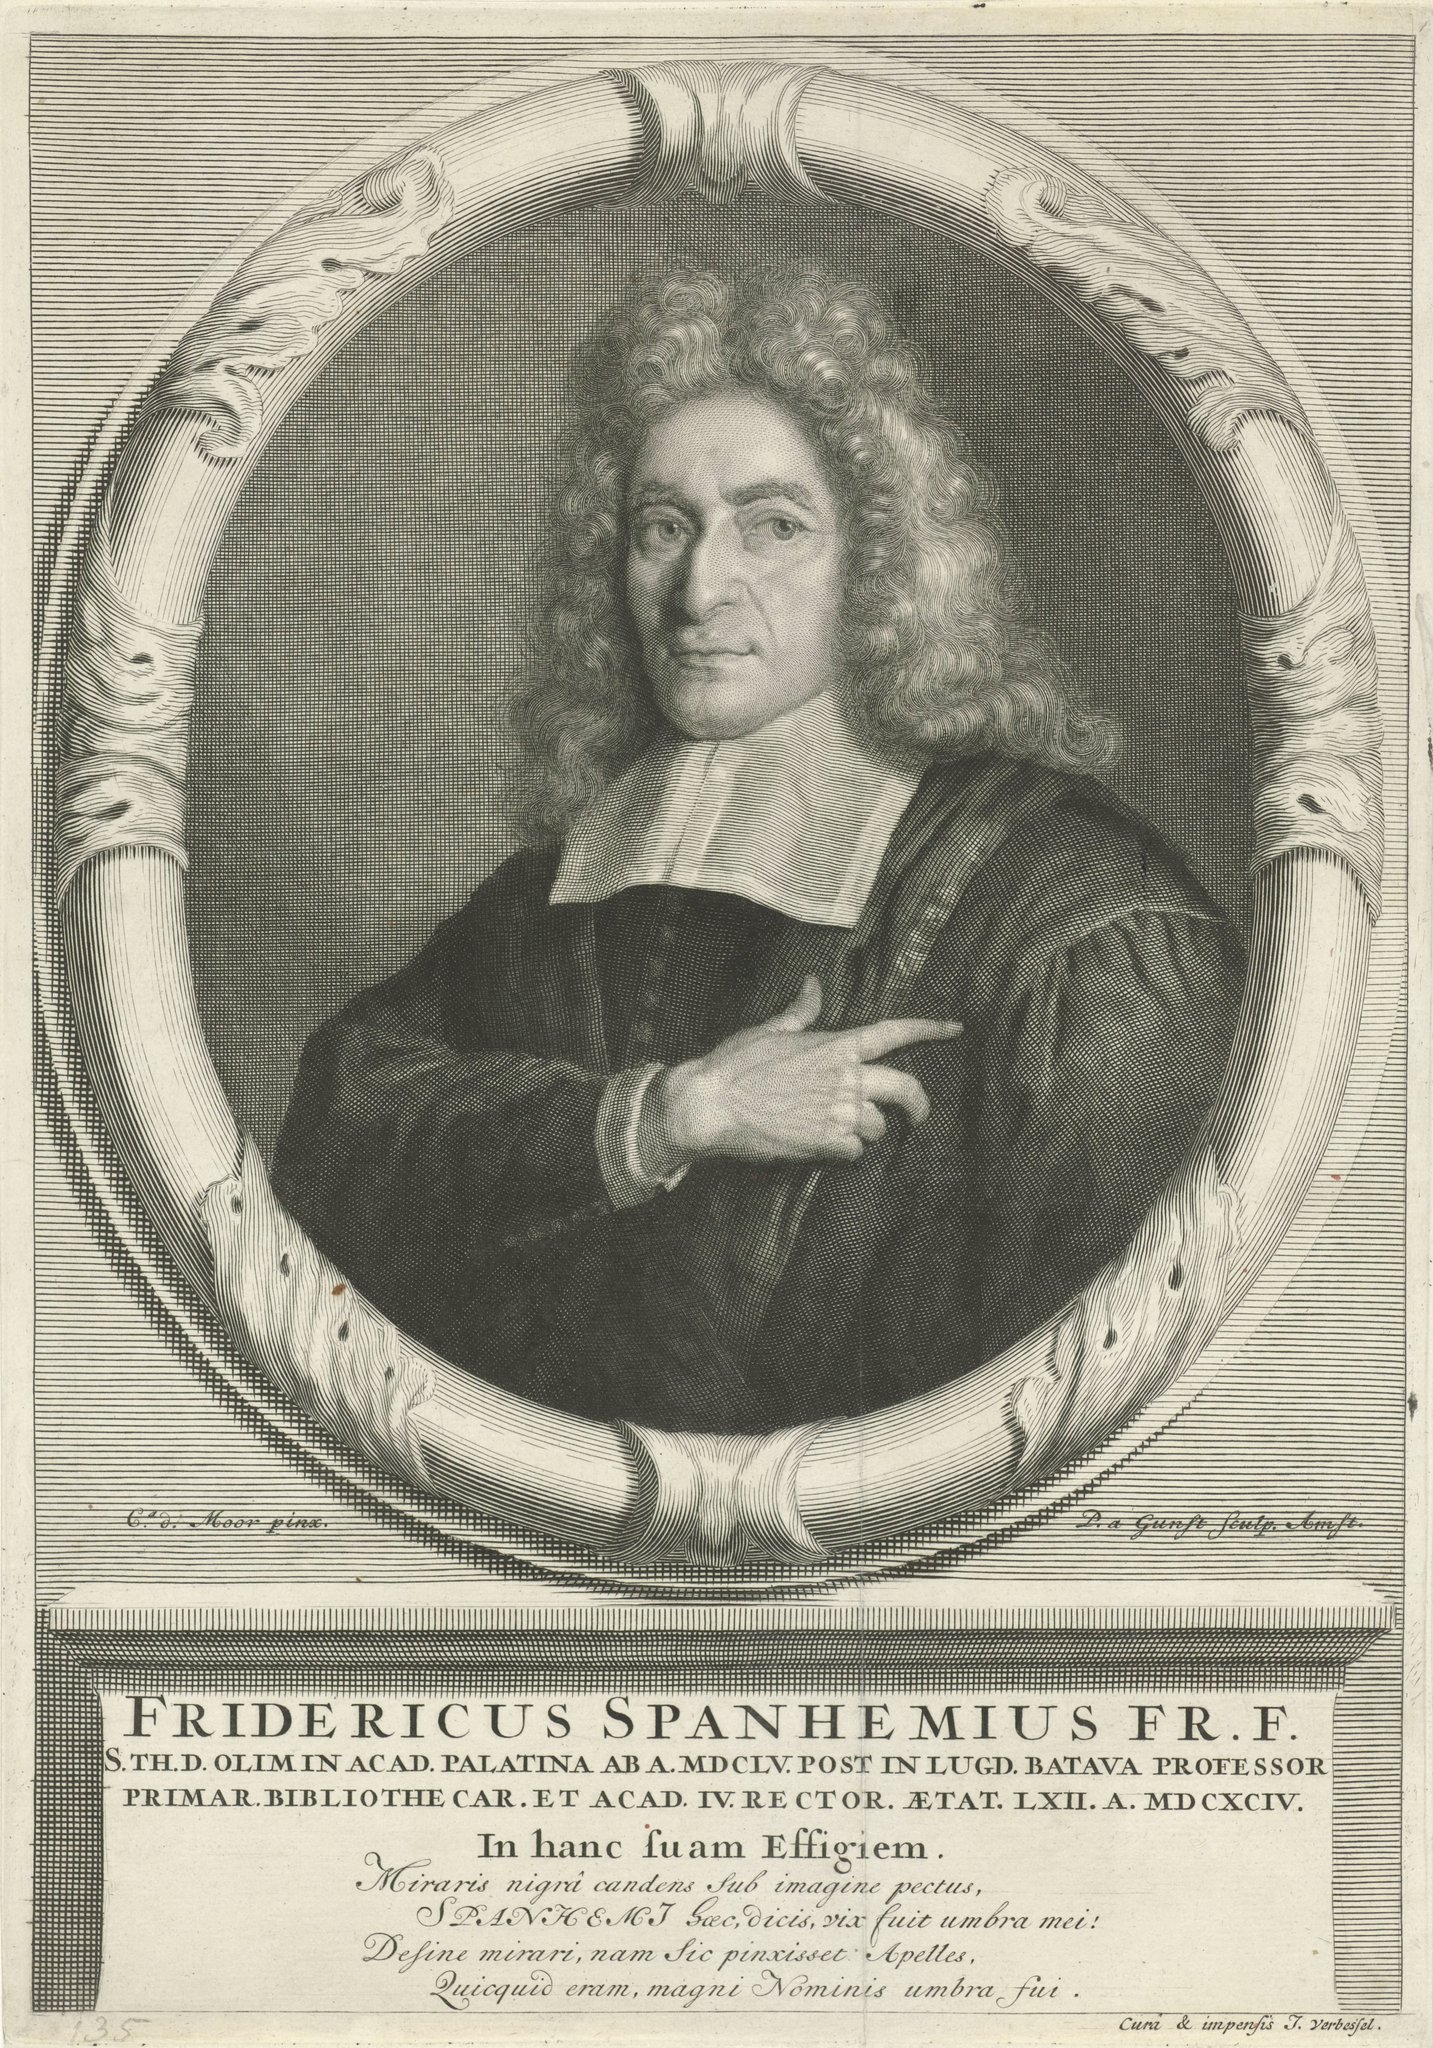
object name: print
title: Portret van Frederick Spanheim de jongere op 62-jarige leeftijd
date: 1694-1731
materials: paper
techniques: engraving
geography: amsterdam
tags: leiden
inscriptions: collector's mark: Lugt 240, collector's mark: Lugt 2228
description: Frederick Spanheim de jongere, Zwitsers theoloog en professor bij de universiteit van Utrecht, op 62-jarige leeftijd. Met Latijns onderschrift.